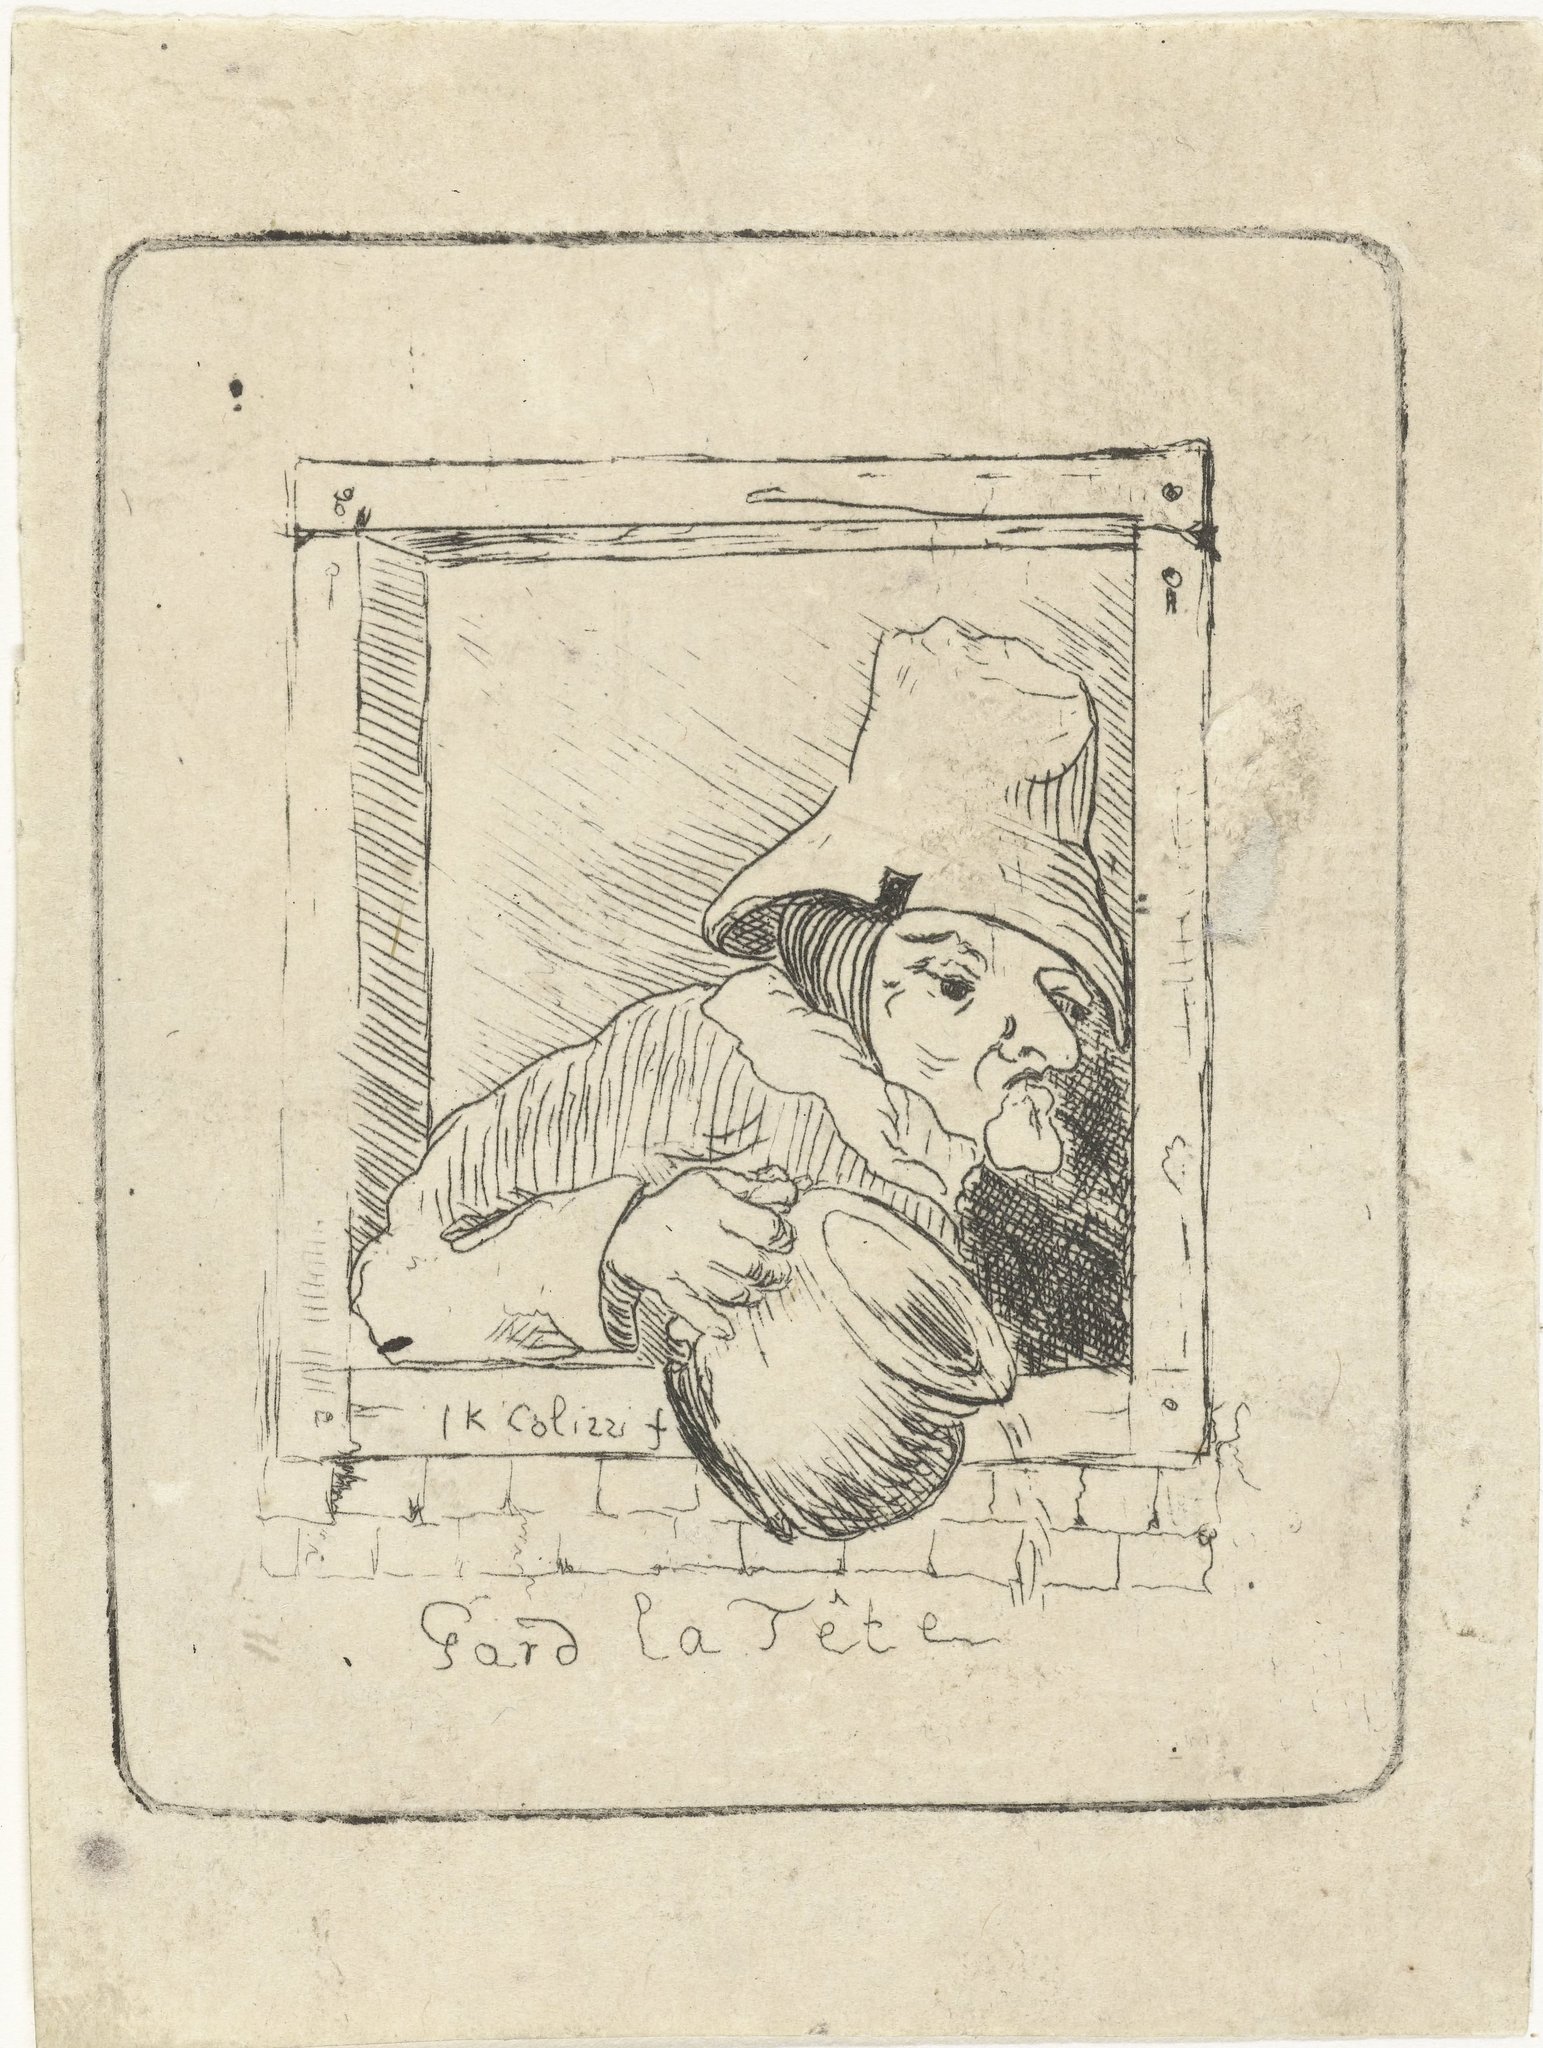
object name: print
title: Gard la Tête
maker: johan antoni kauclitz colizzi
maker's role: print maker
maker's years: 1742-1808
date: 1774-1808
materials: paper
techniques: etching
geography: netherlands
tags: chamber-pot is emptied from above ~ chasing away (unwanted) lover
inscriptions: collector's mark: Lugt 2233